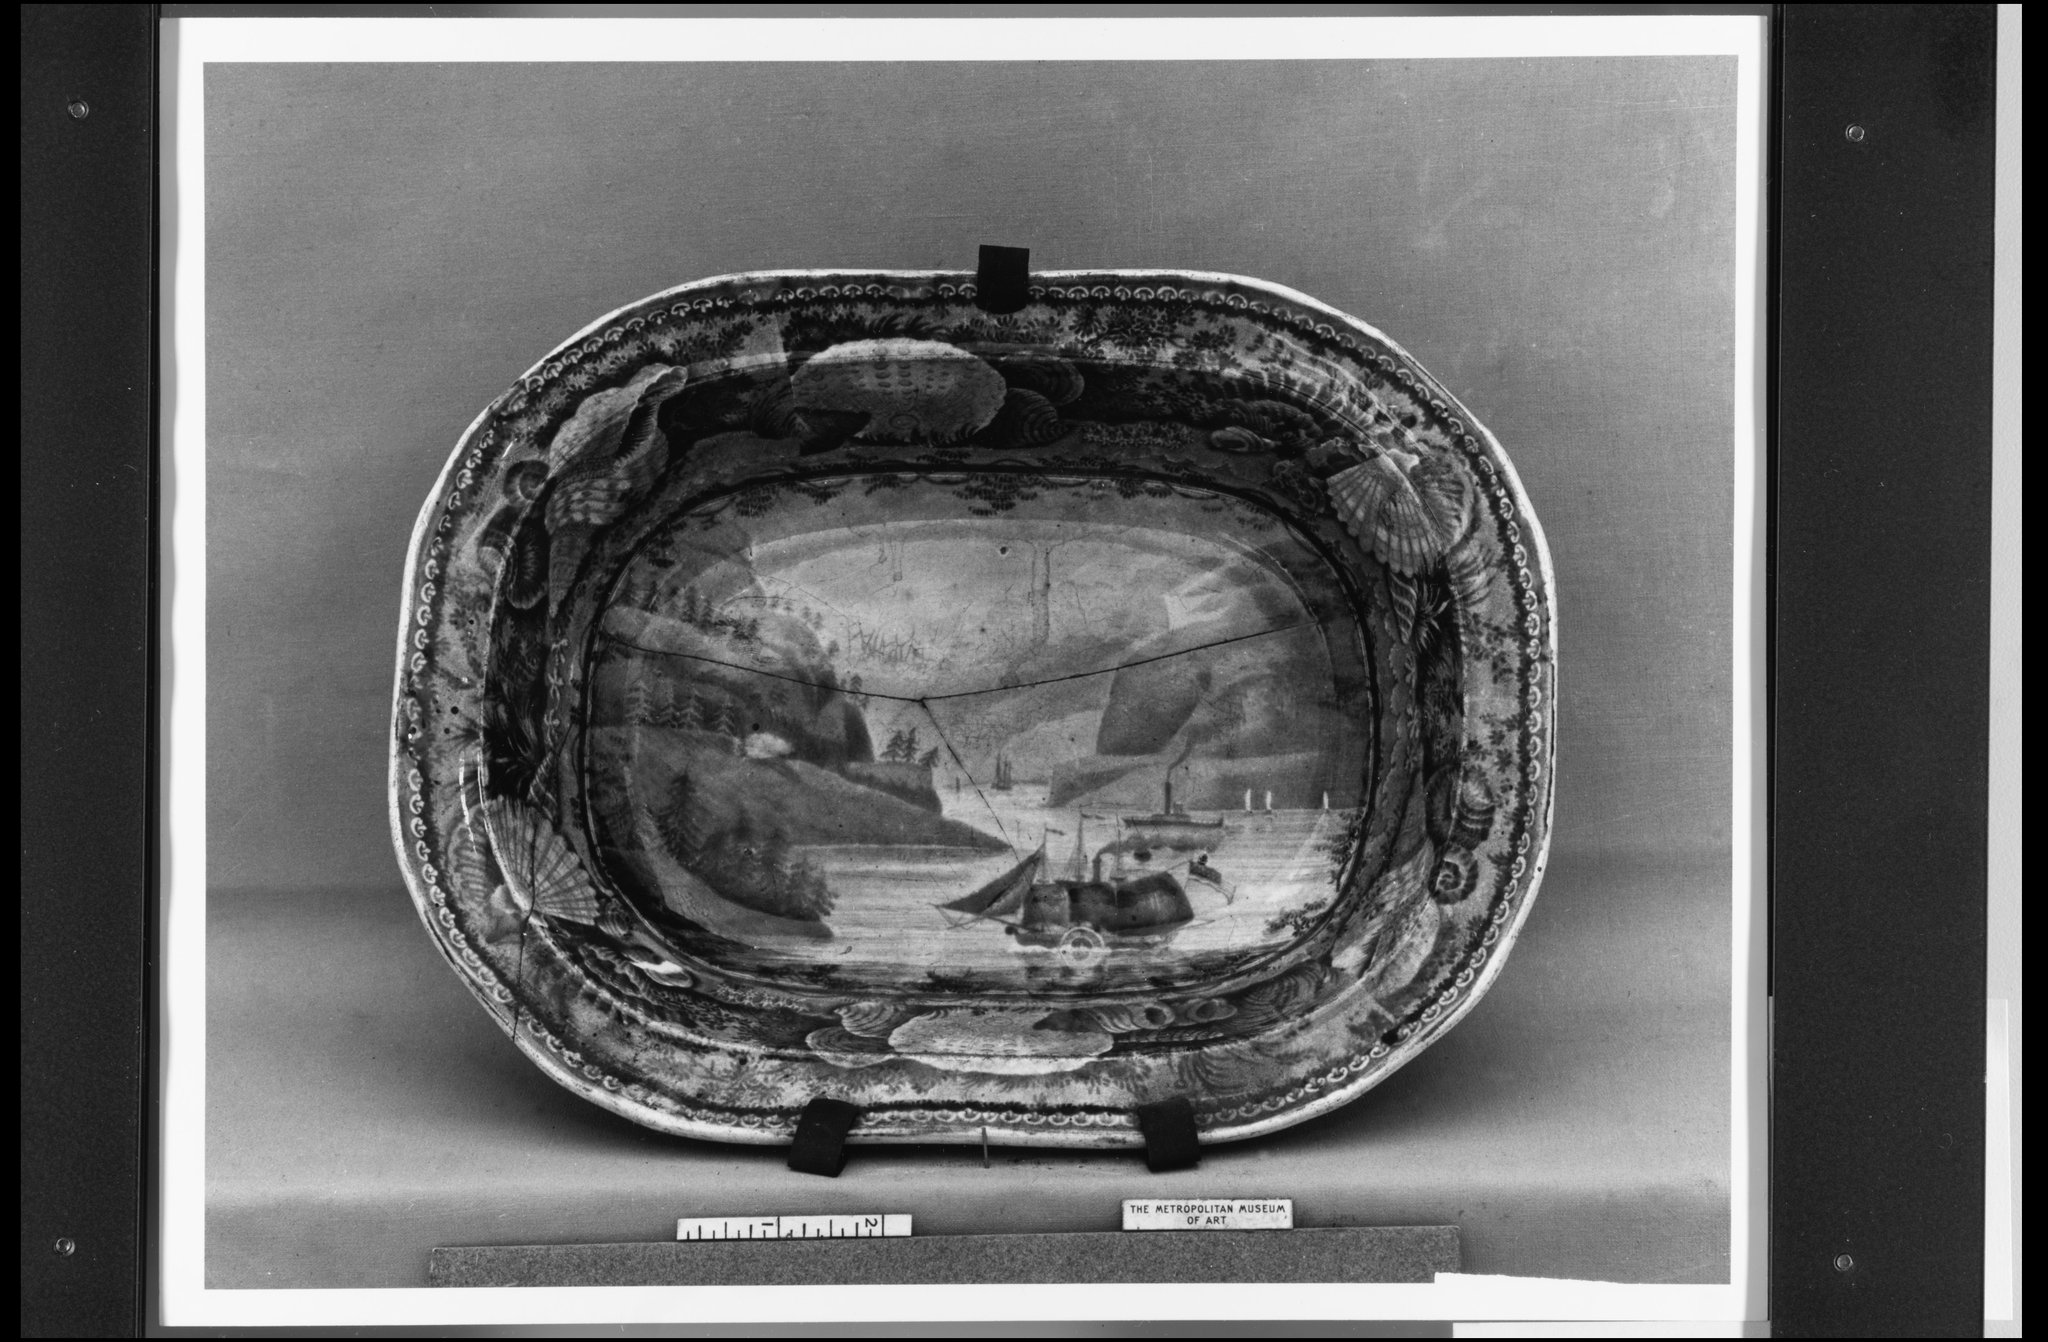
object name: dish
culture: british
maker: enoch wood & sons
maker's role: maker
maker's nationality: british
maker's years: 1818-1846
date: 1821-1846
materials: earthenware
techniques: transfer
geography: england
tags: landscapes,boats